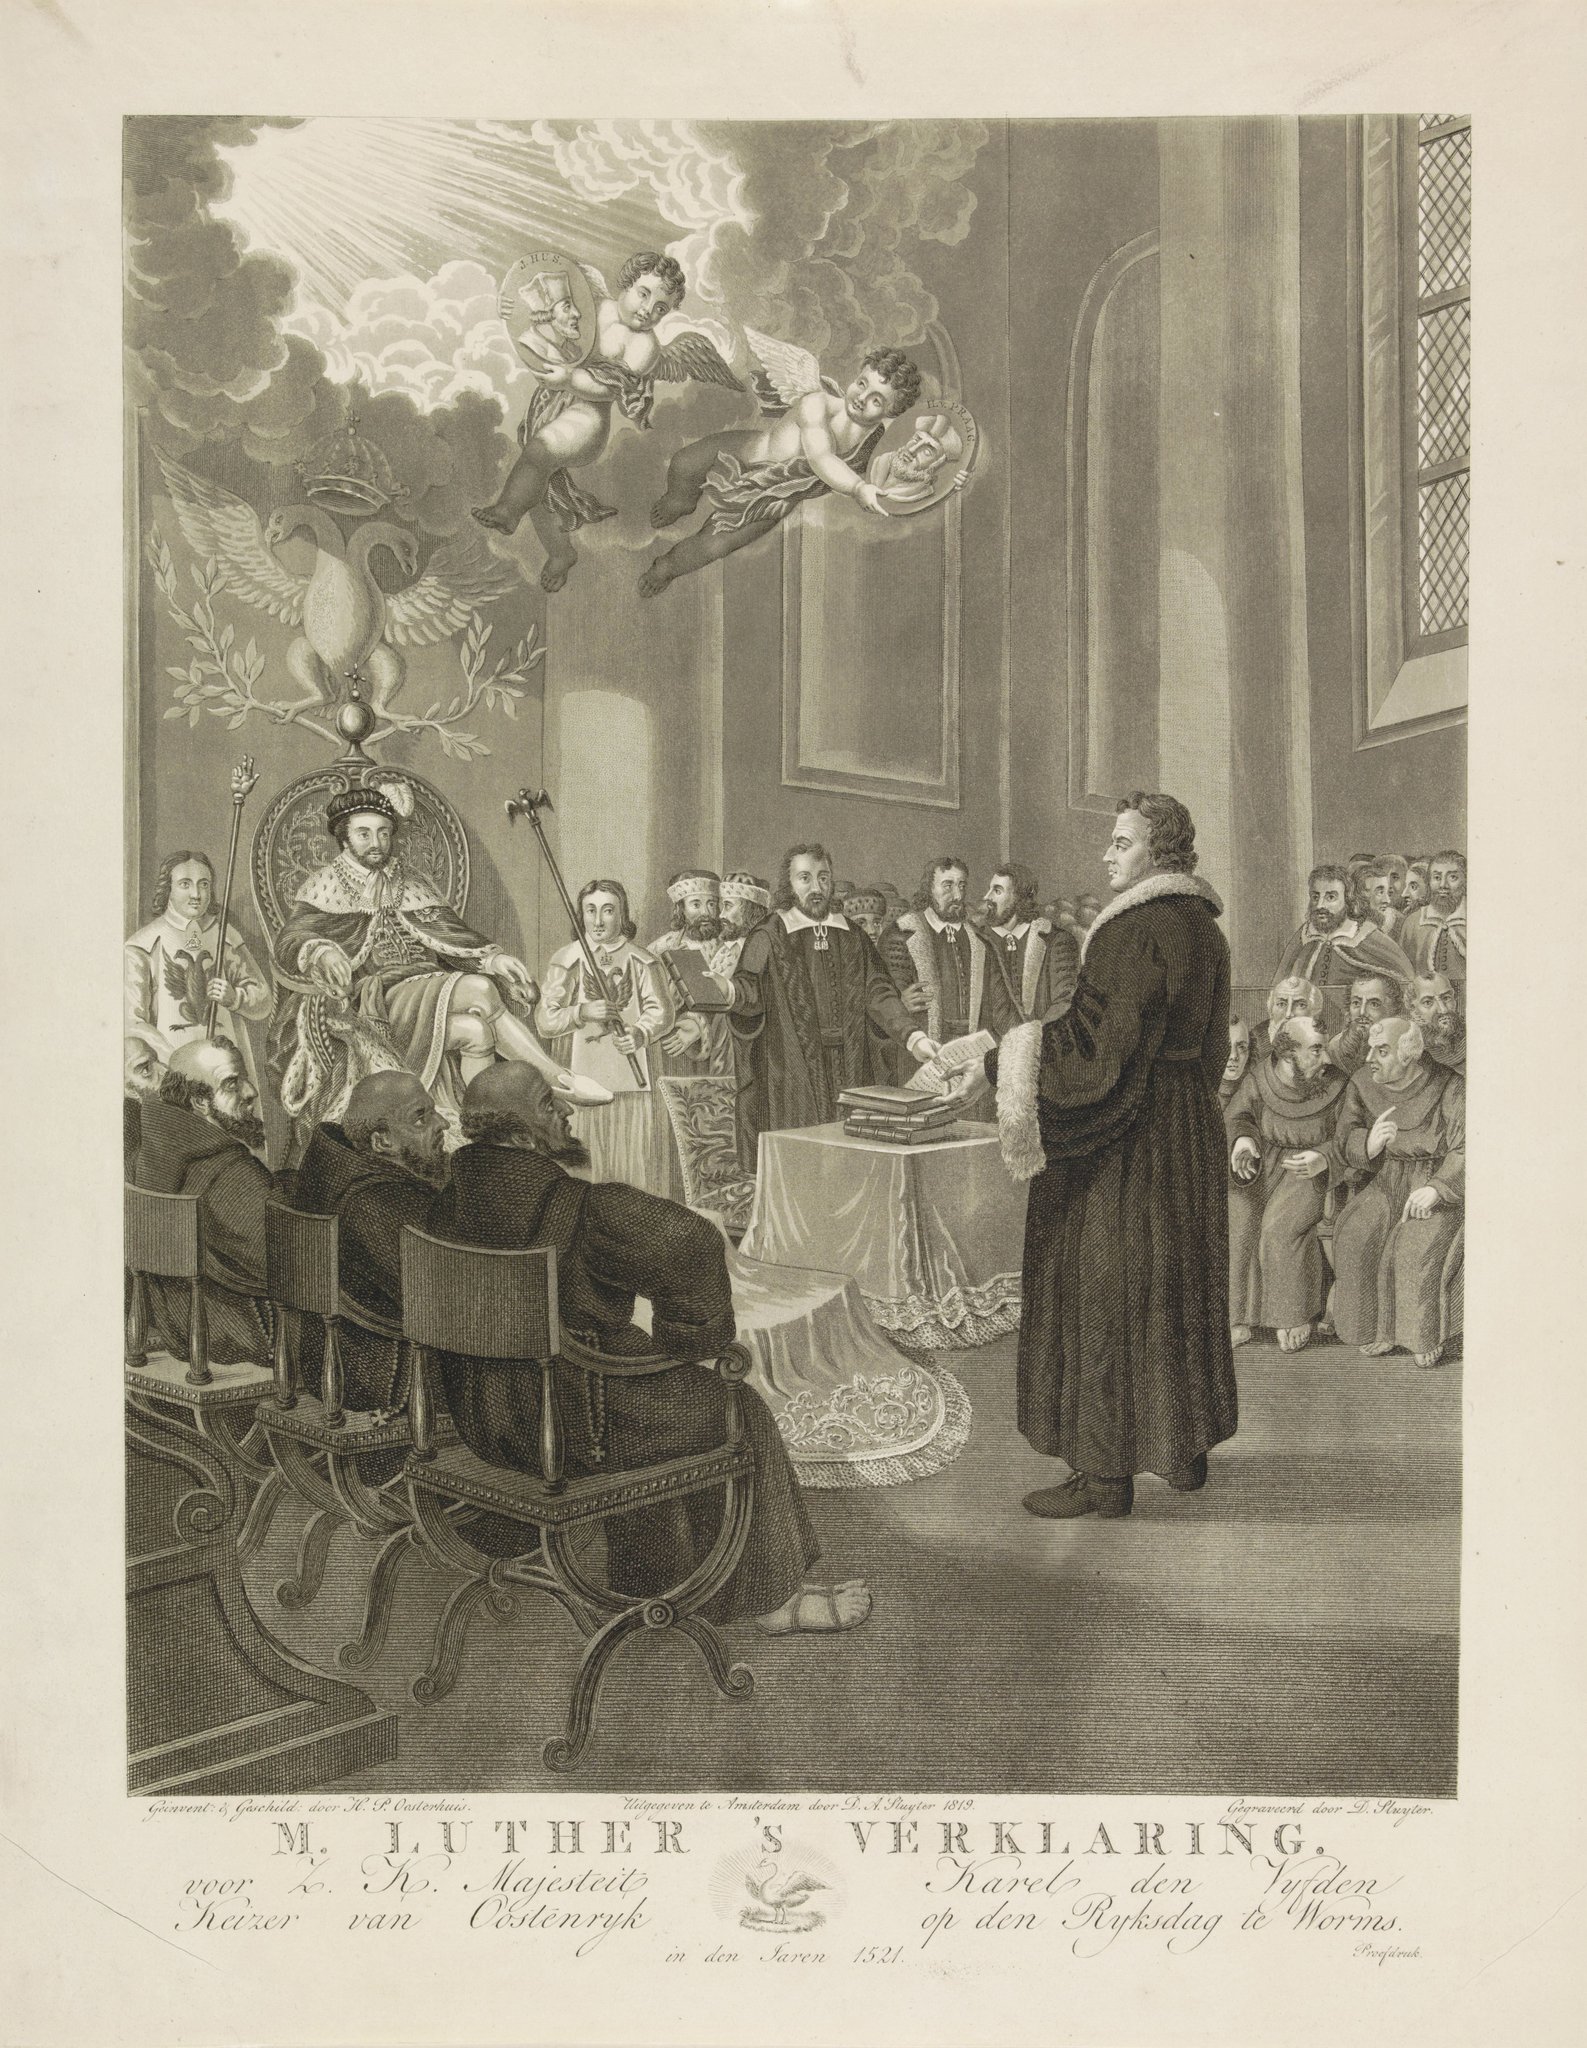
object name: print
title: Luther op de Rijksdag te Worms, 1521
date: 1819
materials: paper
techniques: aquatint, engraving, etching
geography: amsterdam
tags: prague, priest, martin luther, ghent, charles v (holy roman emperor and king of spain), disputing theologians, water-birds: swan, debate, discussion (~ meeting)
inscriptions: collector's mark: Lugt 2228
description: Martin Luther verdedigt zich staande tegenover keizer Karel V op de rijksdag te Worms, 18 april 1521. In de lucht twee putti met portretten van Jan Hus en Hiëronymus van Praag. In het onderschrift een zwaan, het symbool van de Lutherse kerk. Waarschijnlijk ontstaan in het kader van de derde eeuwfeest van de Hervorming, 1517-1817.